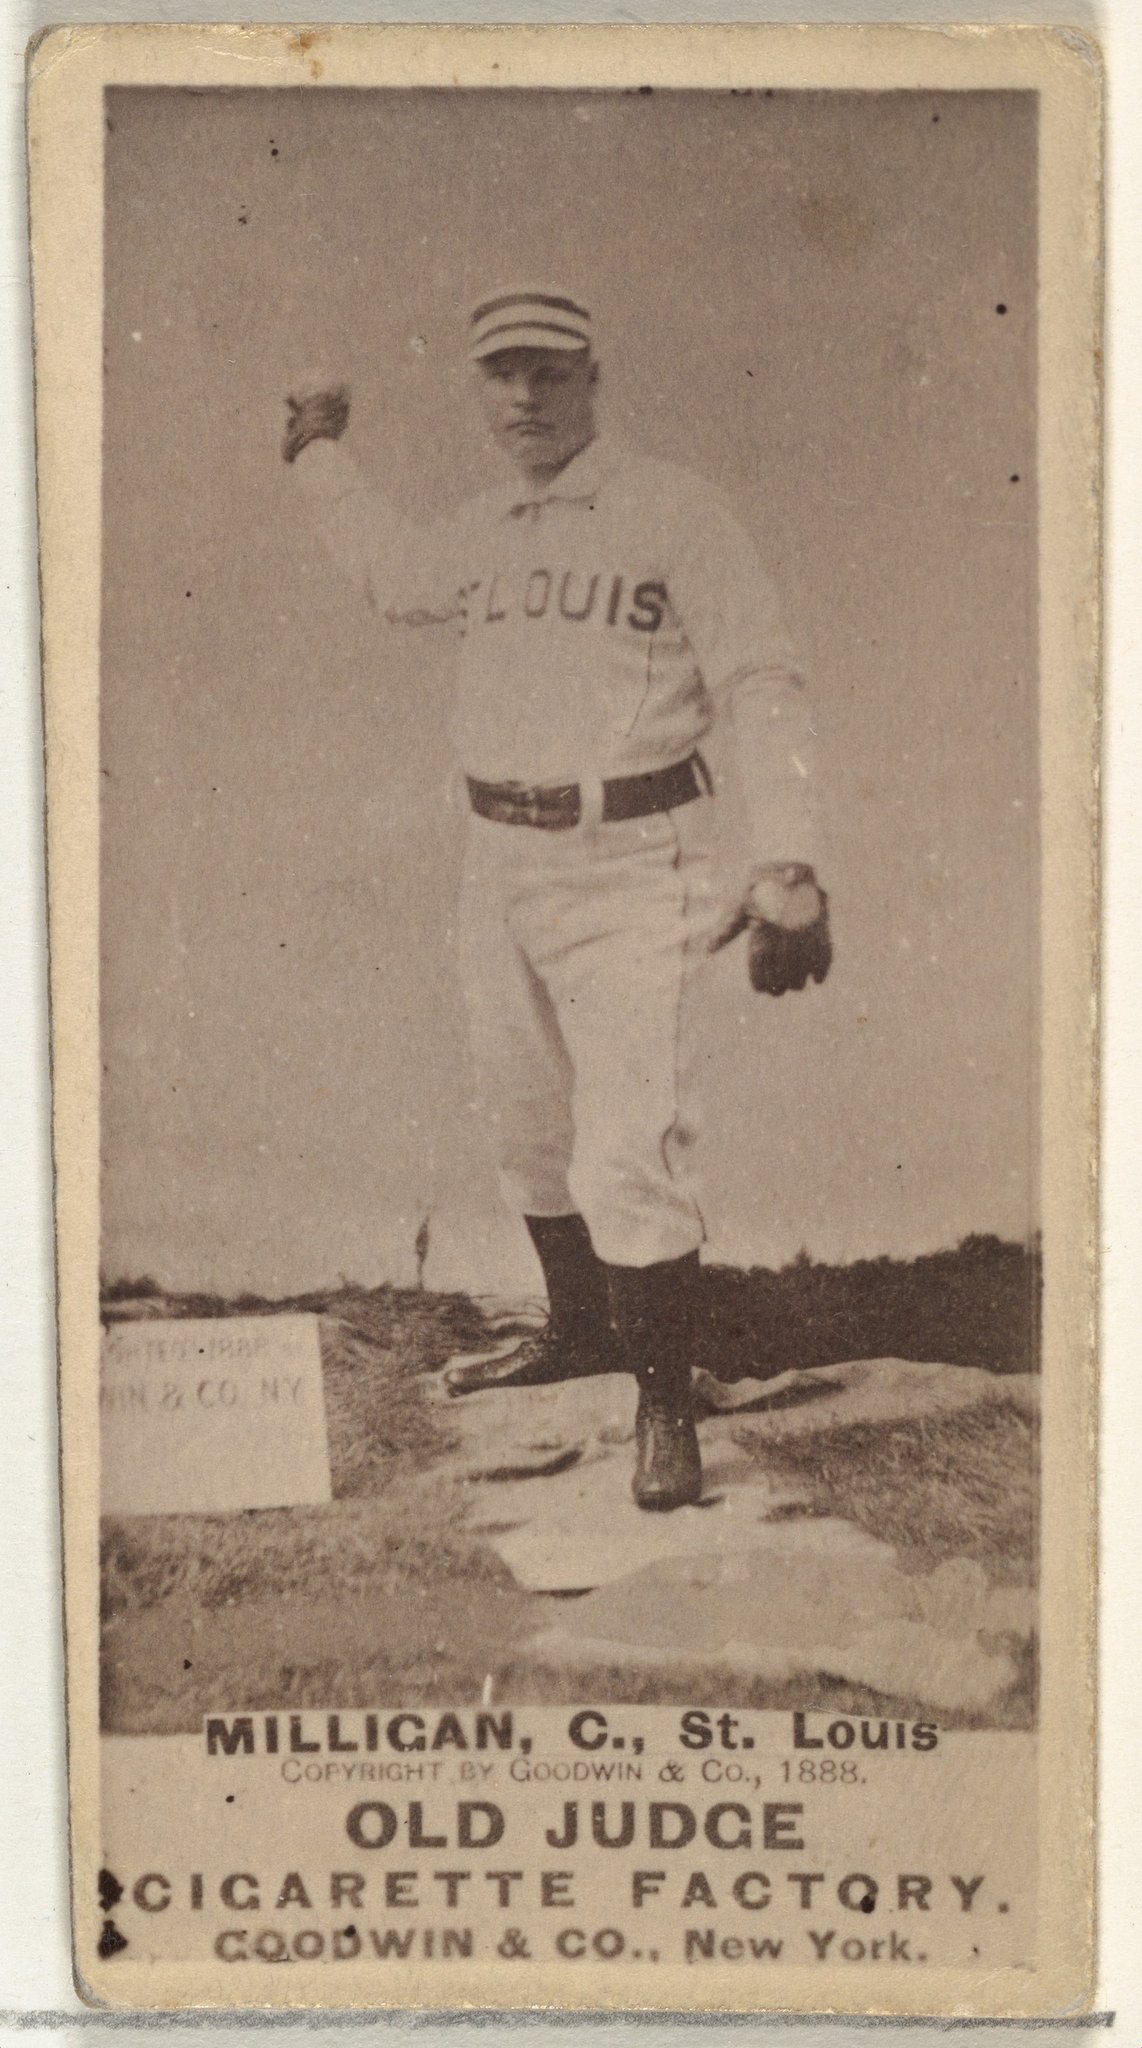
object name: baseball card, photograph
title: Jocko Milligan, Catcher, St. Louis Browns, from the Old Judge series (N172) for Old Judge Cigarettes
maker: goodwin & company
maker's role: publisher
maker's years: 1850-1950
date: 1888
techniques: albumen silver print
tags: men,portraits,baseball,athletes